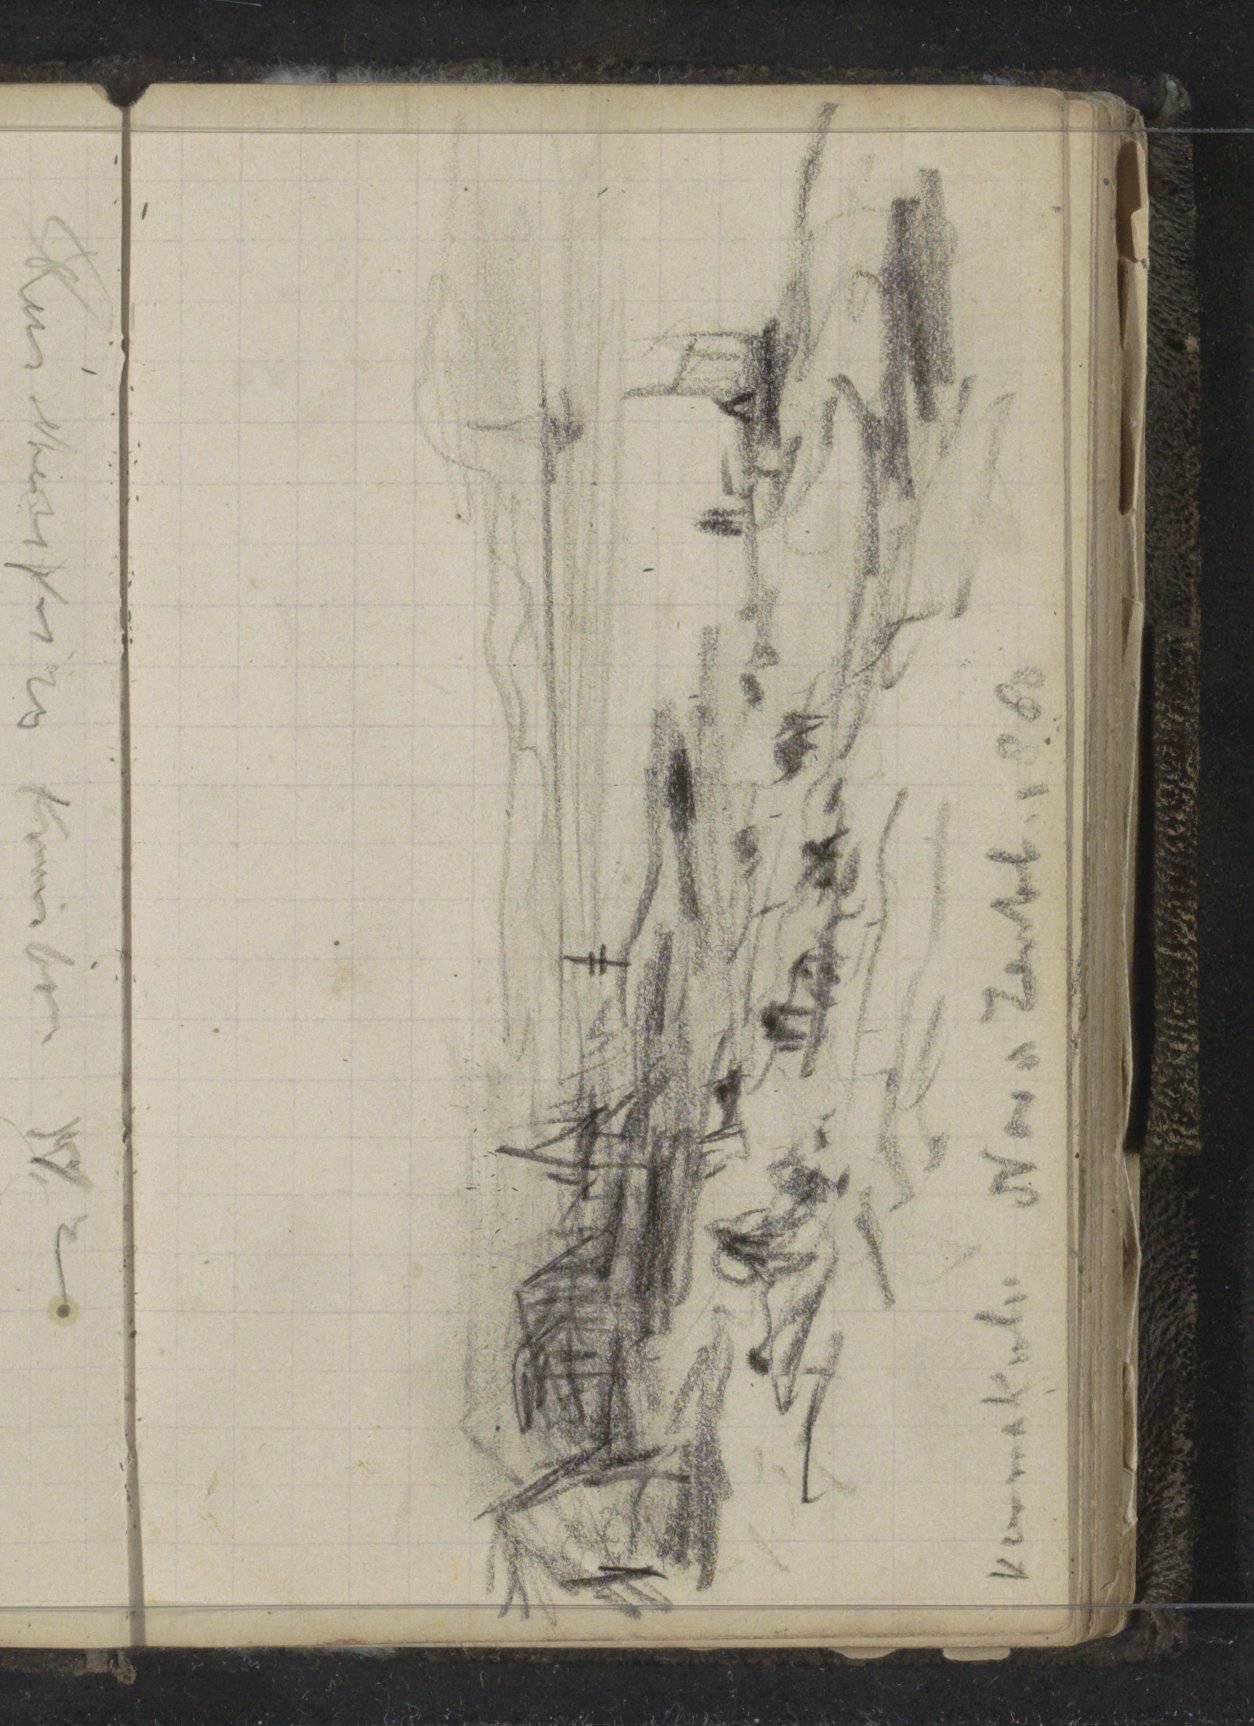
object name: sketchbook leaf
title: Gezicht op de Russische nederzetting te Malye Karmakuly, Nova Zembla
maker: louis apol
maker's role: draughtsman, painter, print maker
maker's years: 1850-1936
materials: chalk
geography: malye karmakuly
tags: village, landscapes in polar regions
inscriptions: annotation: ‘Karmakuli Nova Zembla 1880’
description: Blad 57 recto uit een schetsboek met 110 bladen betekend tijdens de expeditie naar Nova Zembla in 1880.